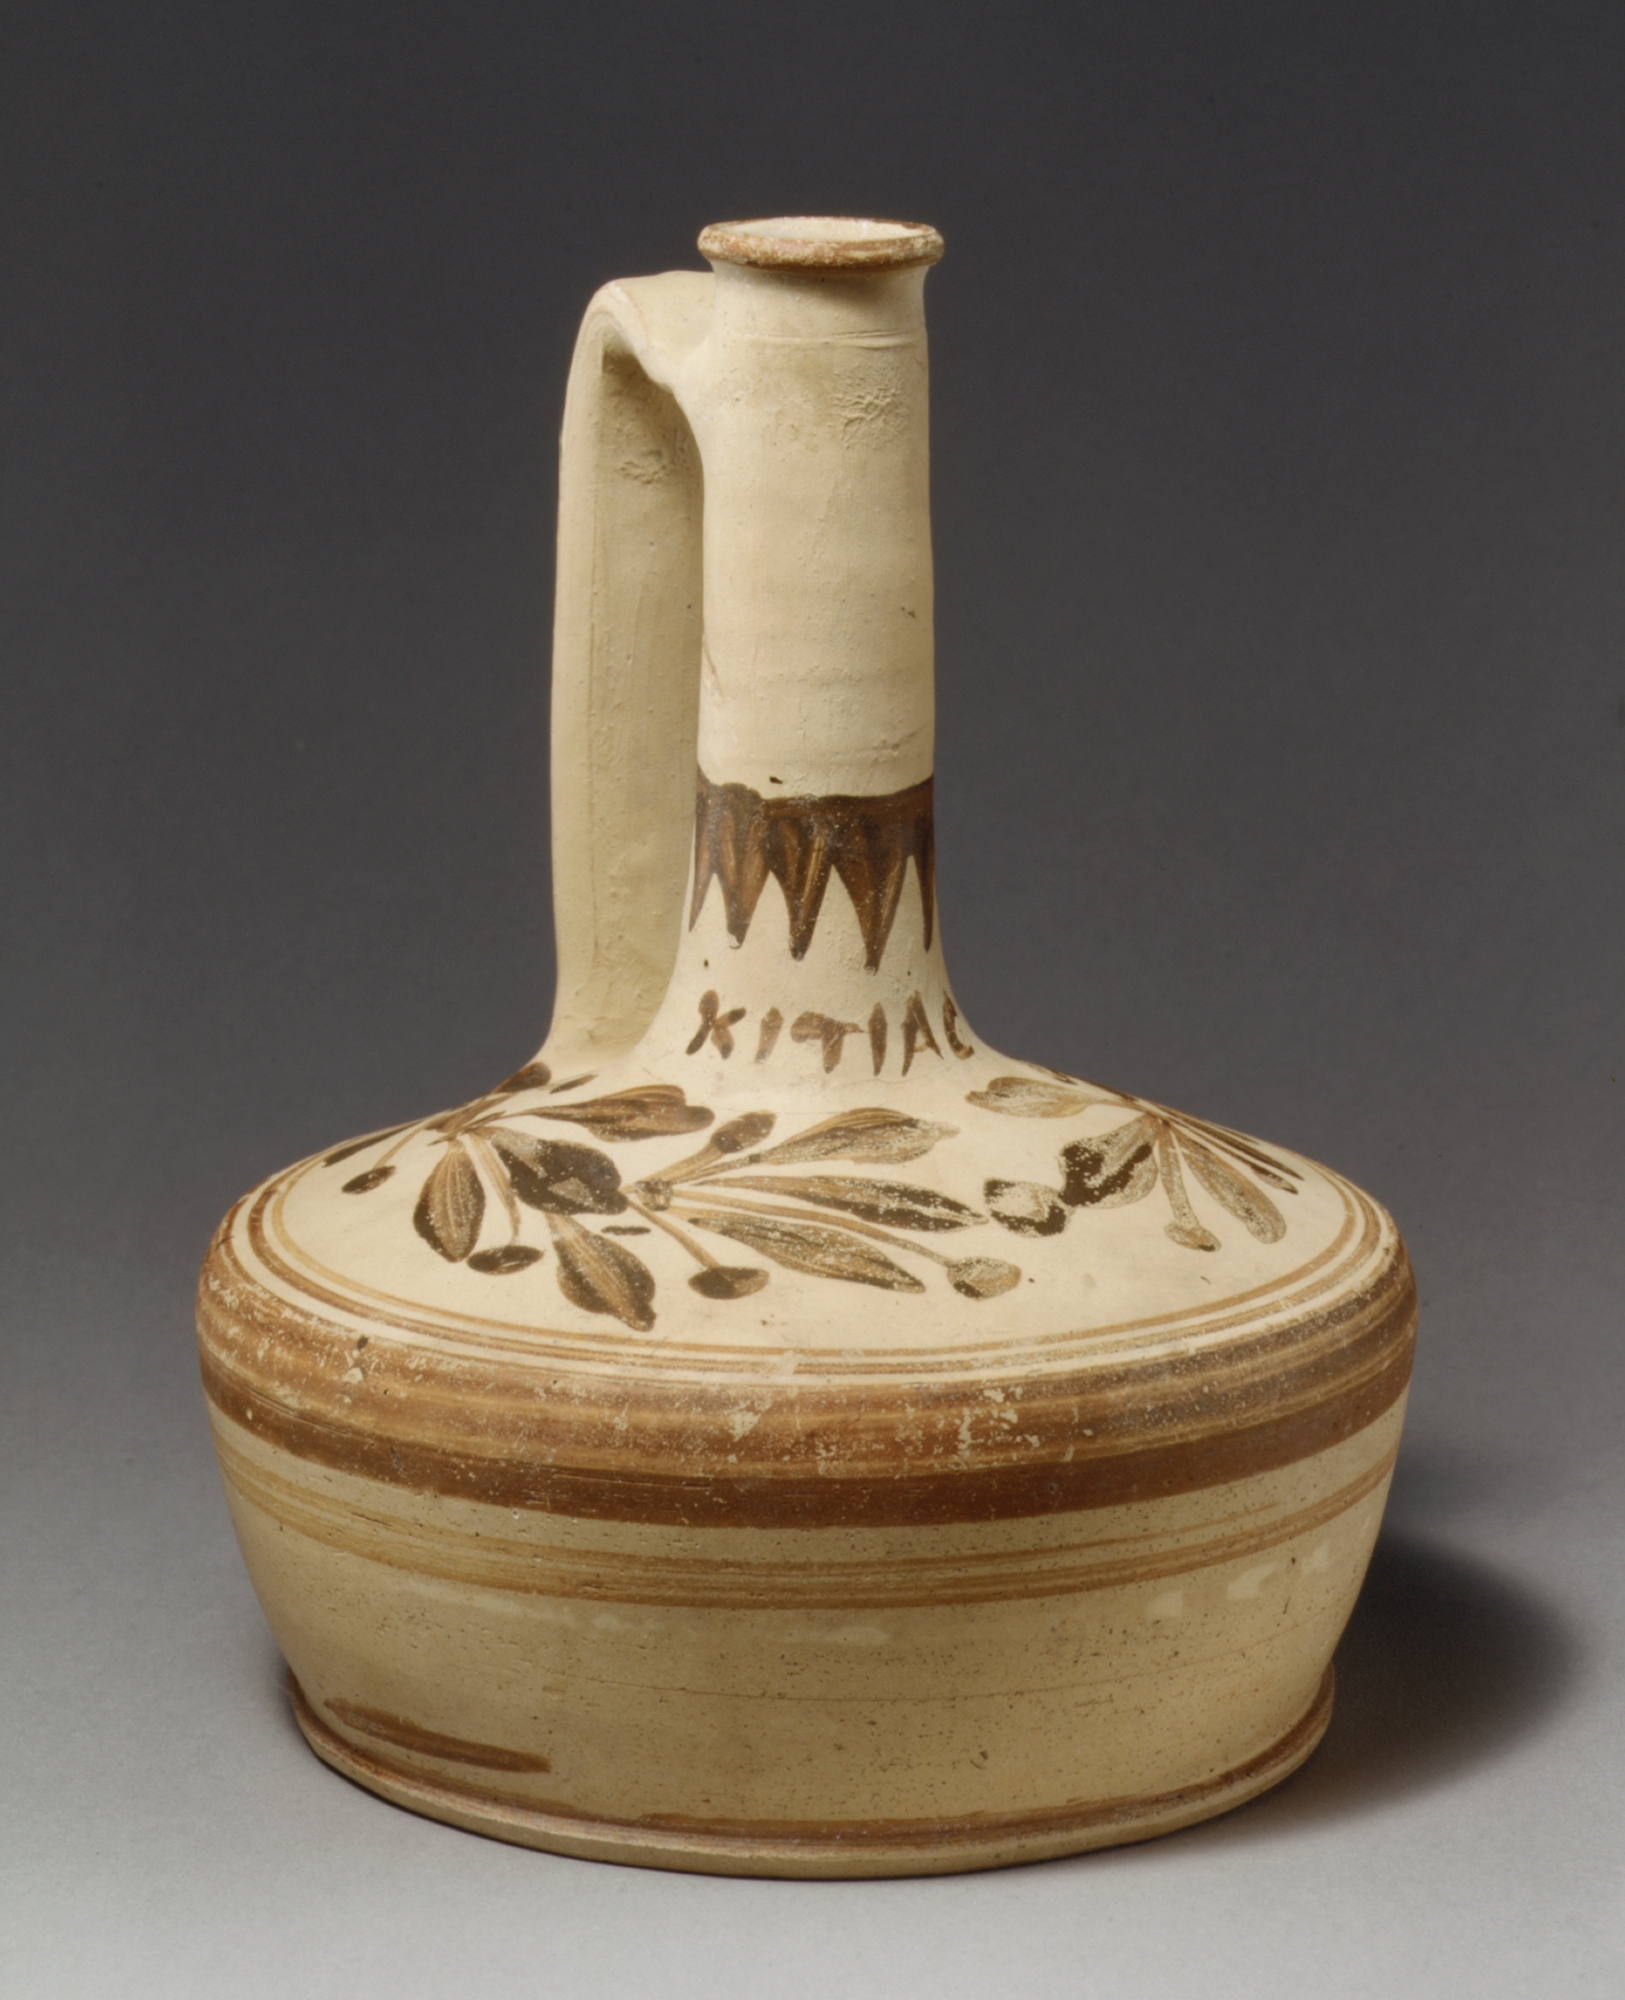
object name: lagynos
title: Terracotta lagynos (pitcher)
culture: cypriot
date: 134-68 BCE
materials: terracotta